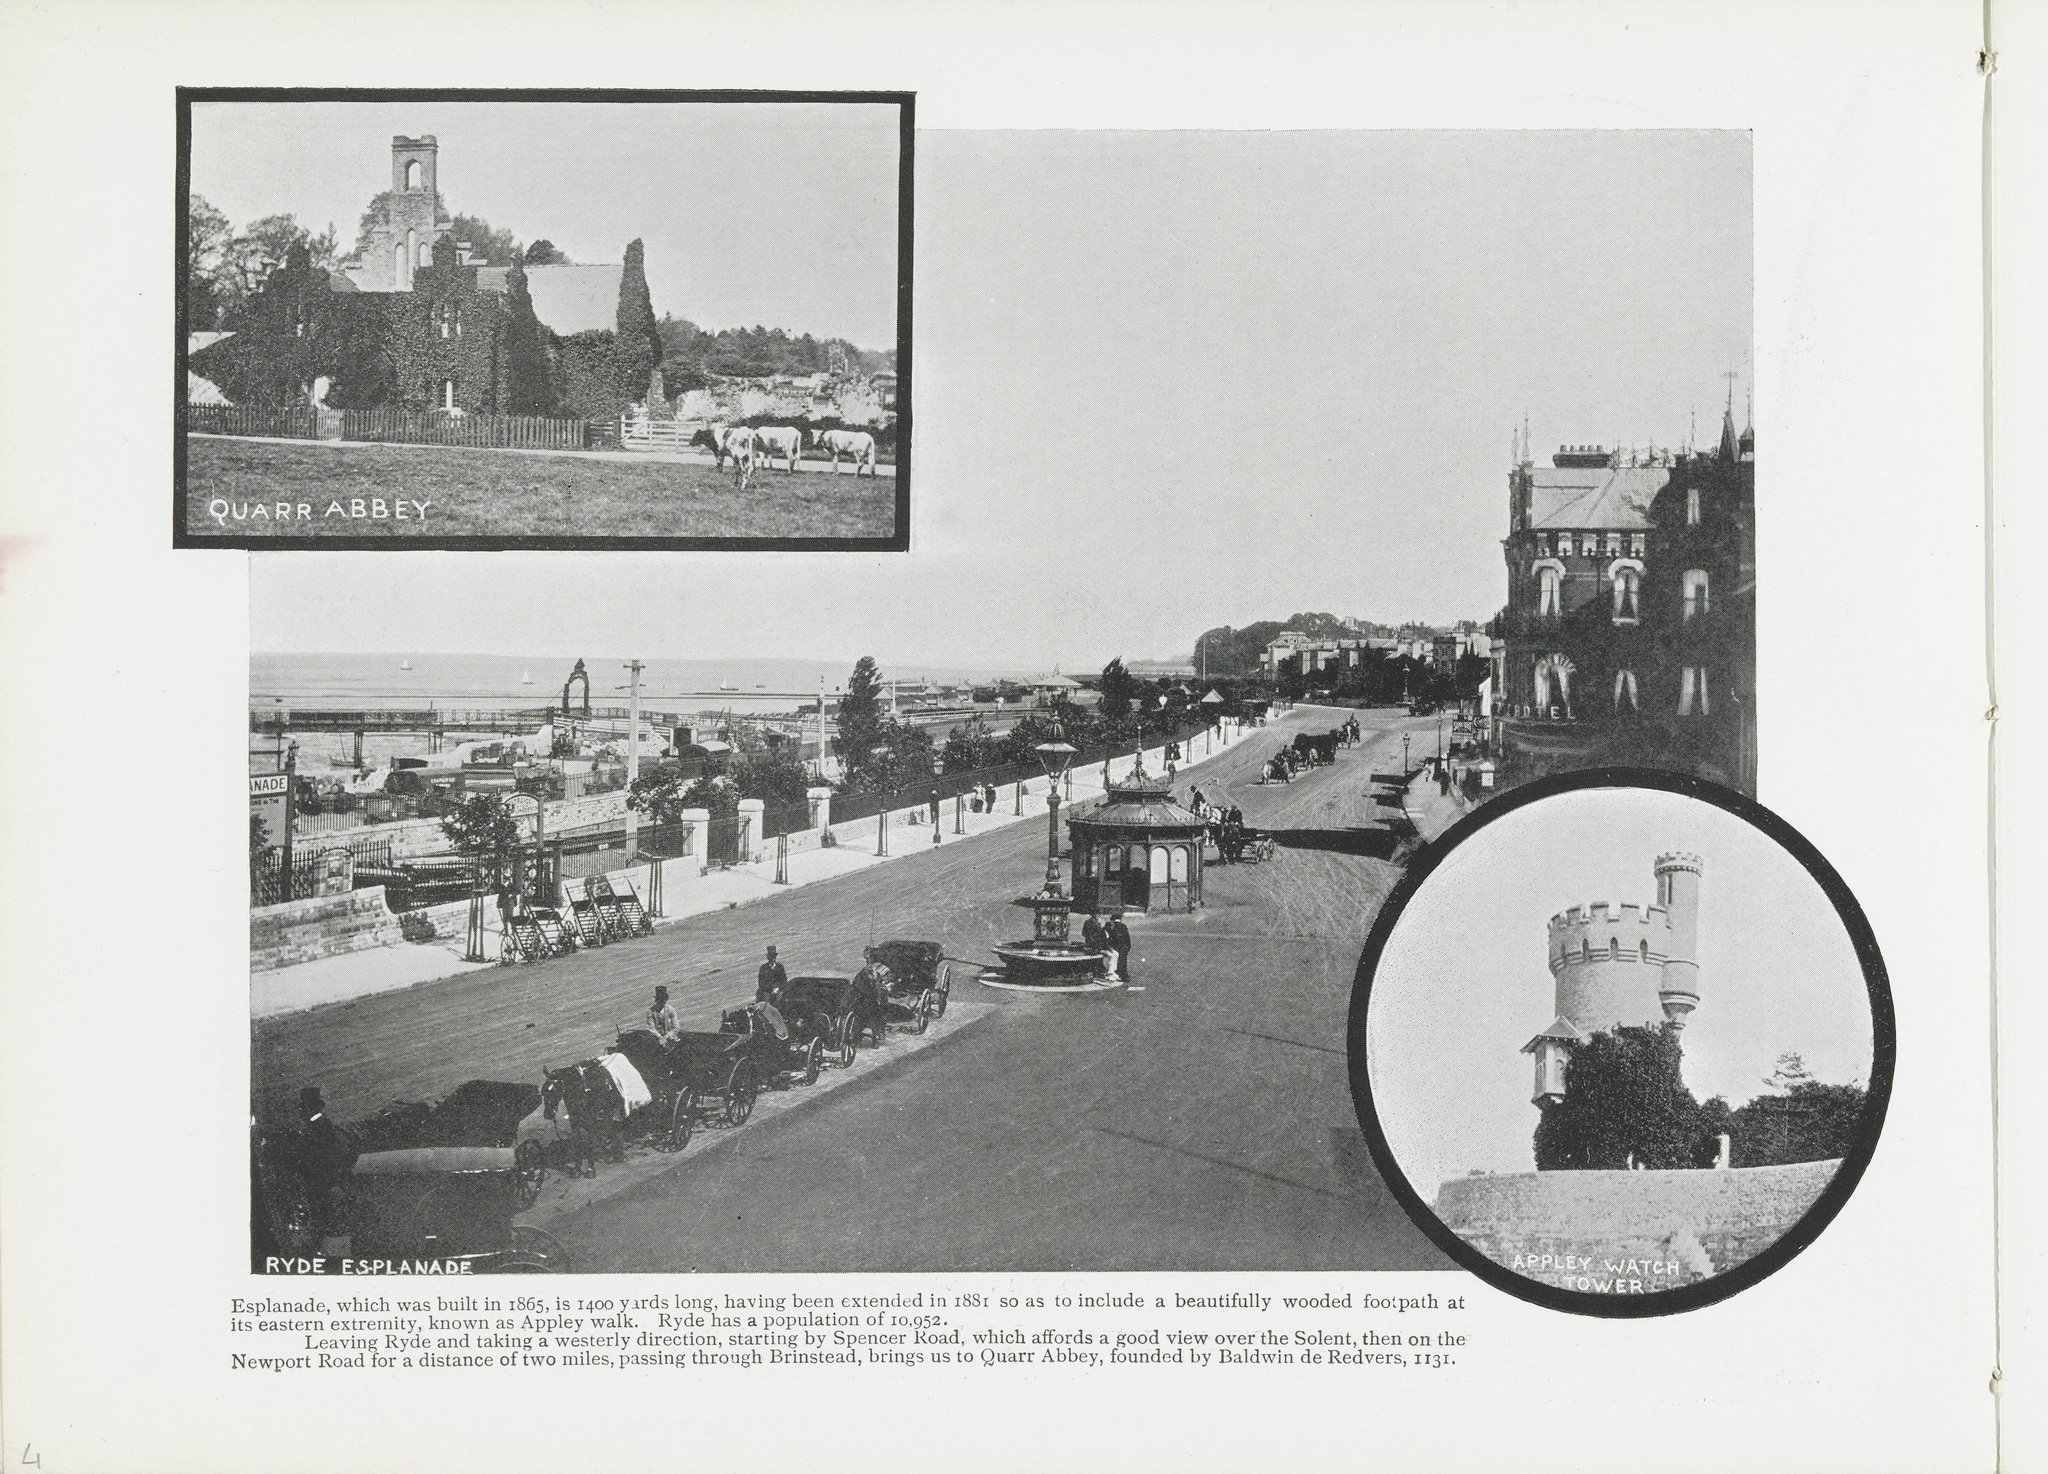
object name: page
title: Quarr Abbey, de Ryde Esplanade en de Appley Watchtower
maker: Anonymous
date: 1897-1930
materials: paper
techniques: printing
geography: st helens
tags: towers ~ fortified city, avenue, boulevard, promenade, esplanade (+ city(-scape) with figures, staffage), abbey, monastery, convent ~ roman catholic church, travelling; tourism, ruin of a dwelling, house, castle, etc.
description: Pagina 4 met 3 foto's van Quarr Abbey, de Ryde Esplanade en de Appley Watchtower en een bijschrift. Onderdeel van Fotografische reisreportage van het eiland Wight.